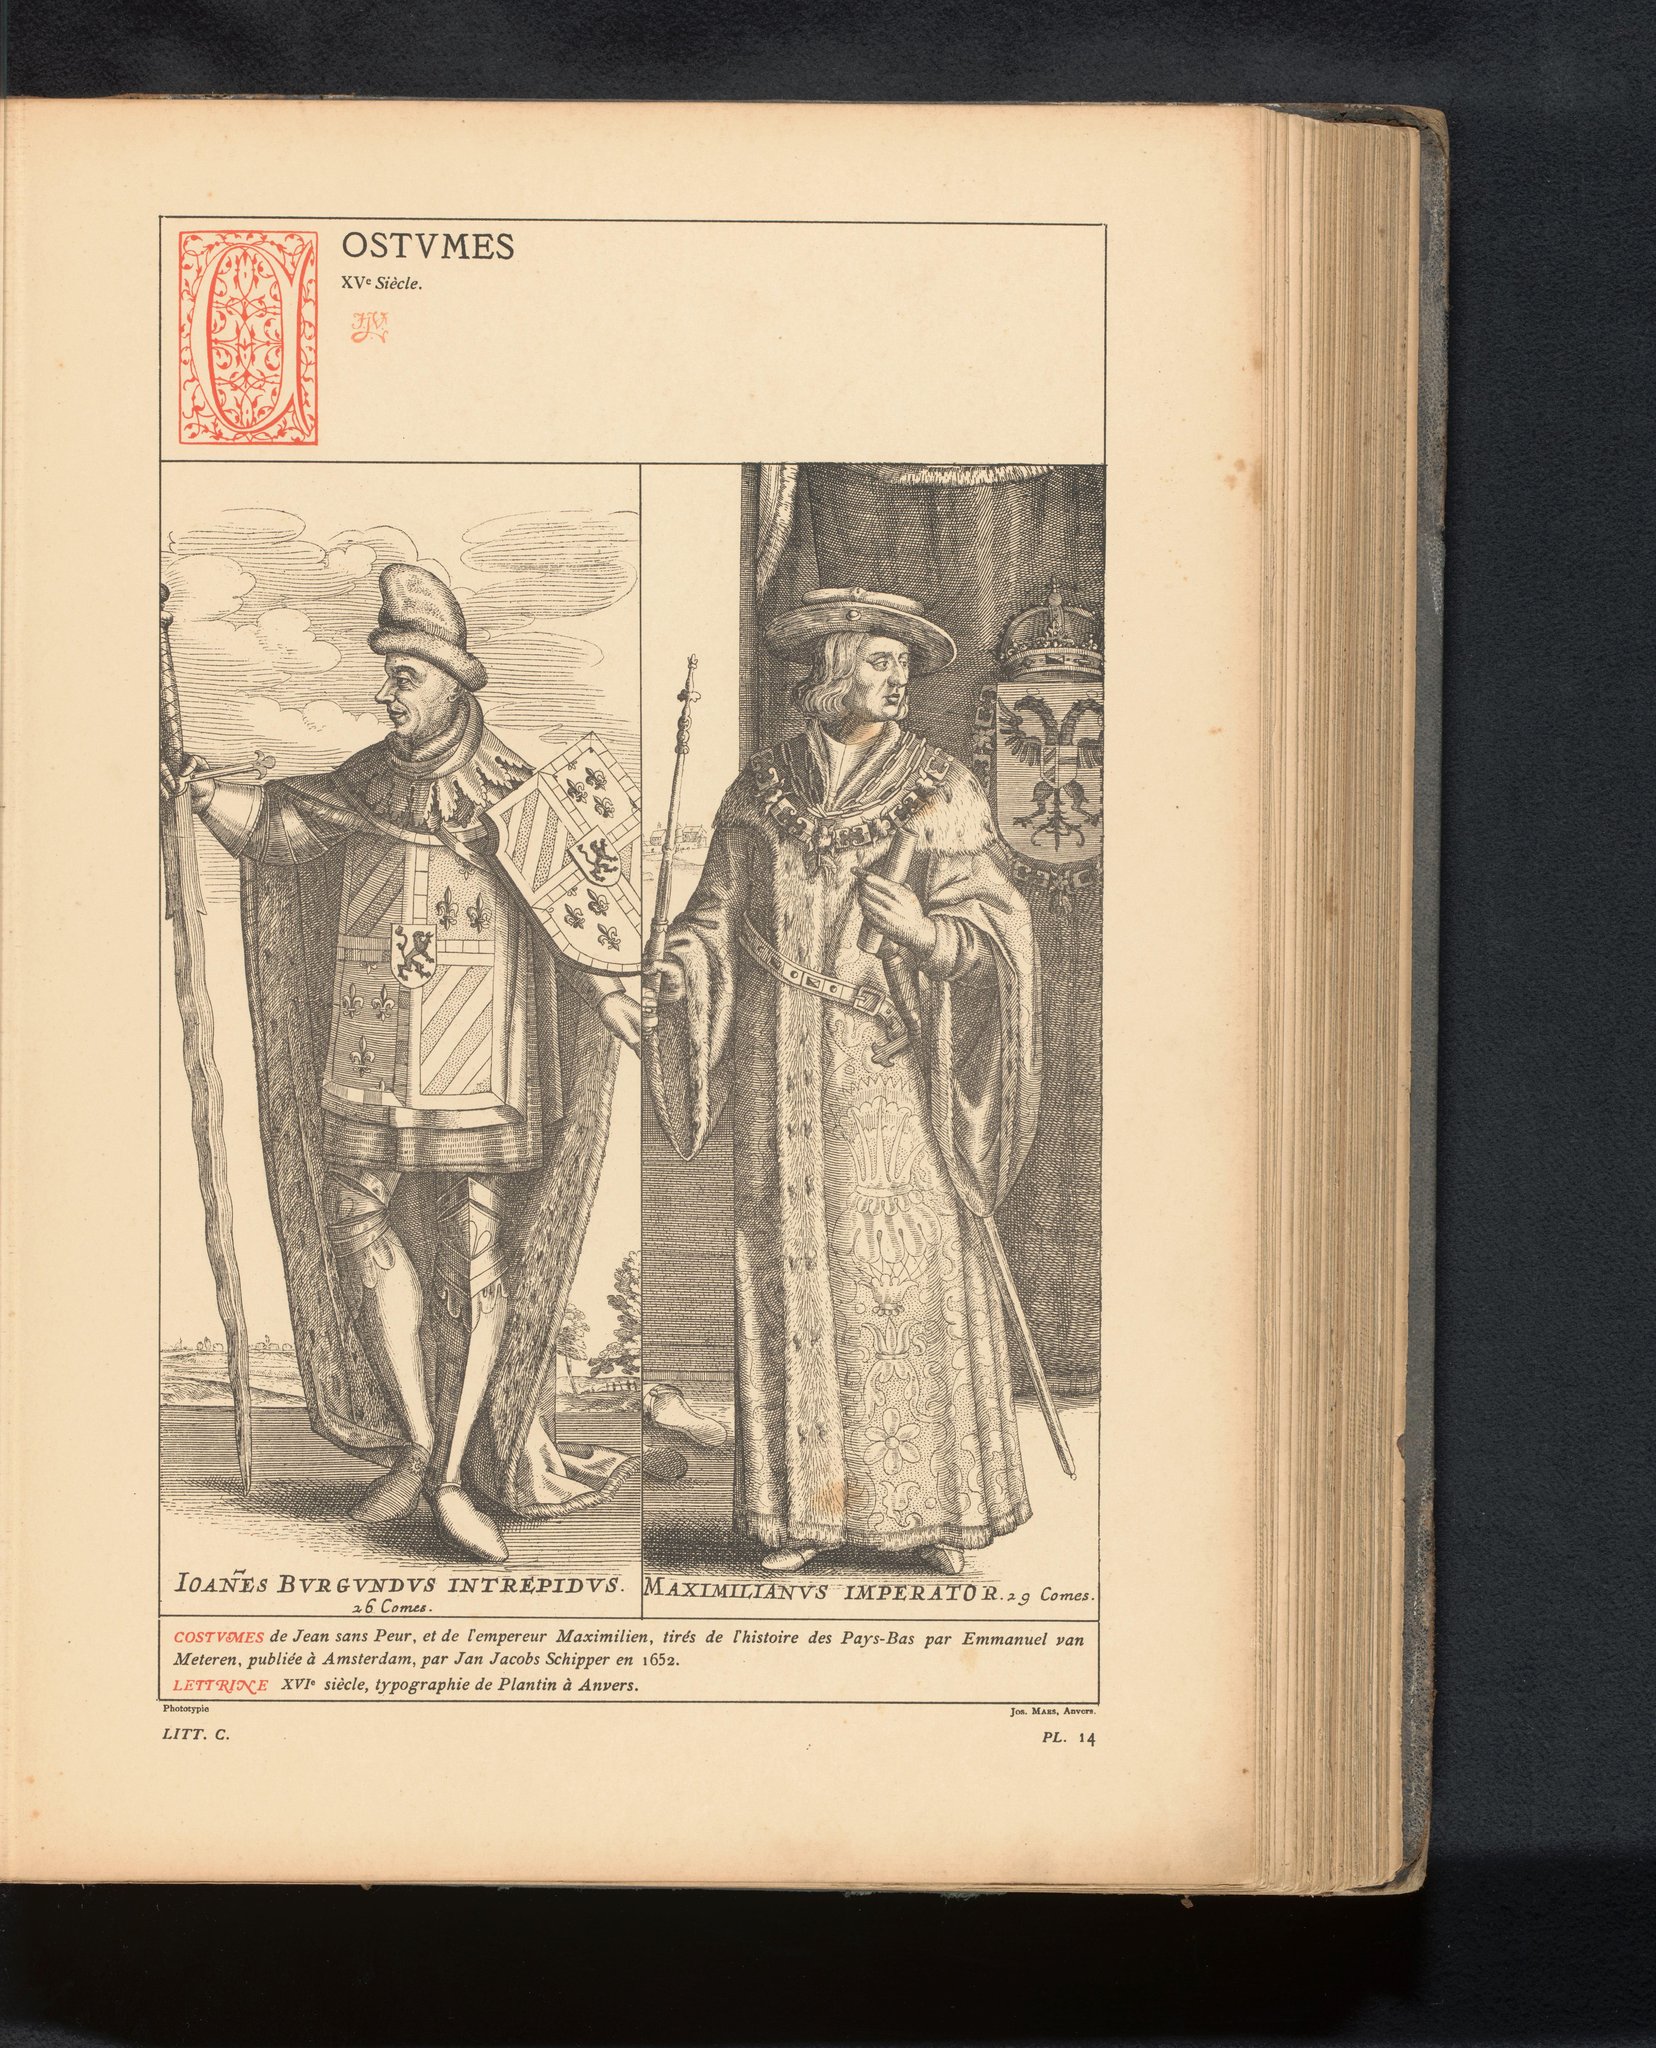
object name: photomechanical print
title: Reproductie van twee ontwerpen van kostuumprenten met Jan zonder Vrees en Keizer Maximiliaan I door Emanuel van Meteren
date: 1875-1880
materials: paper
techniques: photolithography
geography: antwerp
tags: maximiliaan i (keurvorst van beieren), emperor, clothes, costume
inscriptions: inscription: ‘LITT: C. - PL. 14’, inscription: ‘Costumes de Jean (...)’, monogram: ‘JJvY’